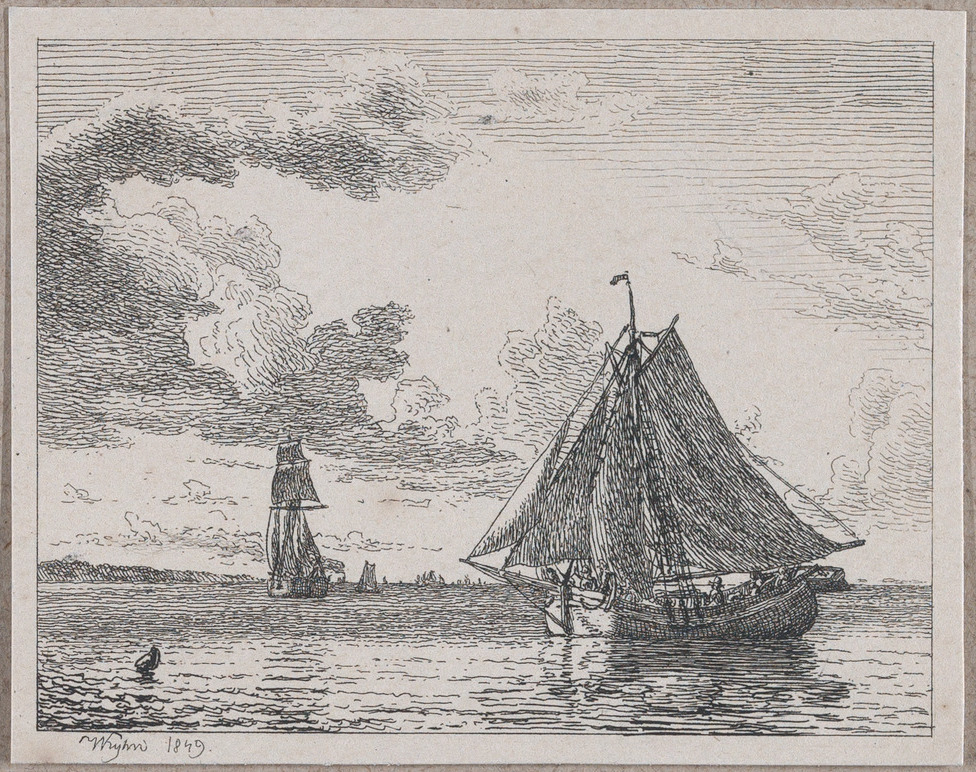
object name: print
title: Maritime View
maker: peter vilhelm carl kyhn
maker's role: artist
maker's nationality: danish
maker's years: 1819-1903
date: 1849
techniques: etching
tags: boats